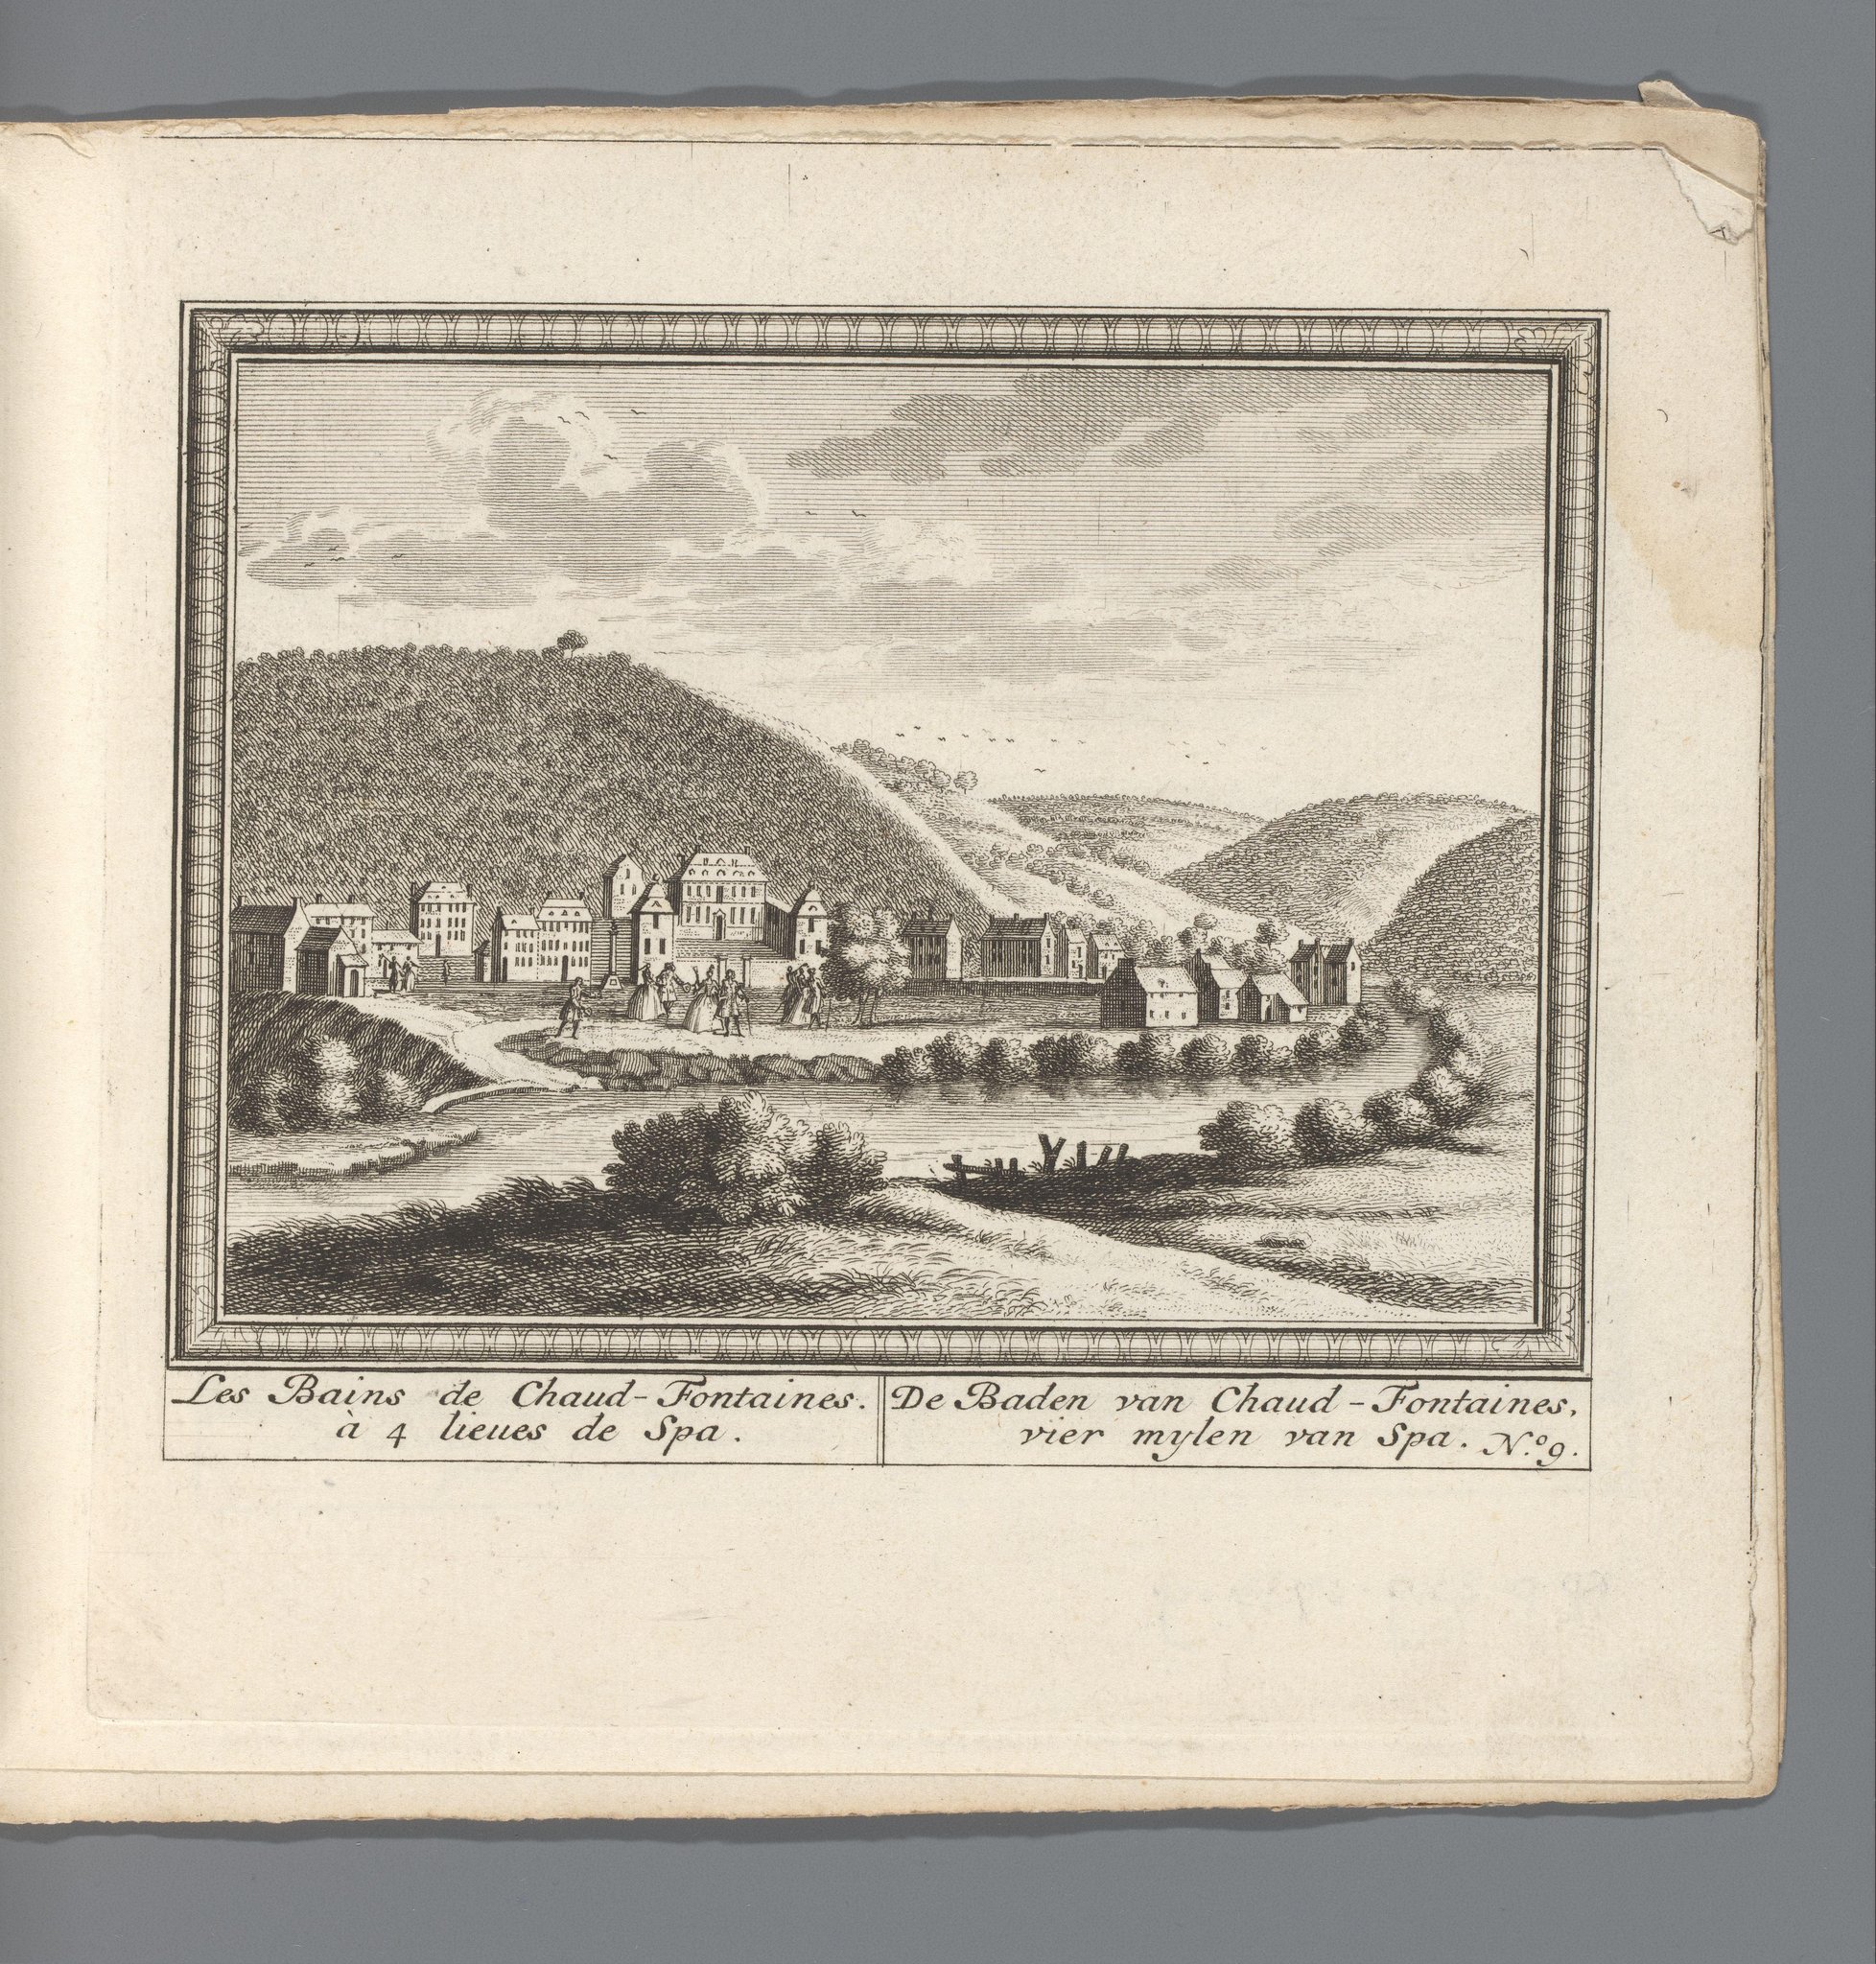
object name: print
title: Gezicht op de baden van Chaudfontaine bij Spa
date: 1734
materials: paper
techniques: etching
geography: amsterdam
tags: city-view in general; 'veduta', mineral water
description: Deze serie prenten is gebruikt in: Pöllnitz, Charles-Louis. Amuseums des eaux de Spa. Ouvrage utile a ceux qui vont boire ces eaux minérales sur les lieux. 2 dln. Amsterdam: Pieter Mortier, 1734. In deze uitgave zijn de prenten echter gevouwen. Mogelijk is deze serie een losse uitgave van de prenten. Er ontbreekt één prent die in het boek is opgenomen (nr. 4), waarop geen landschap is afgebeeld.